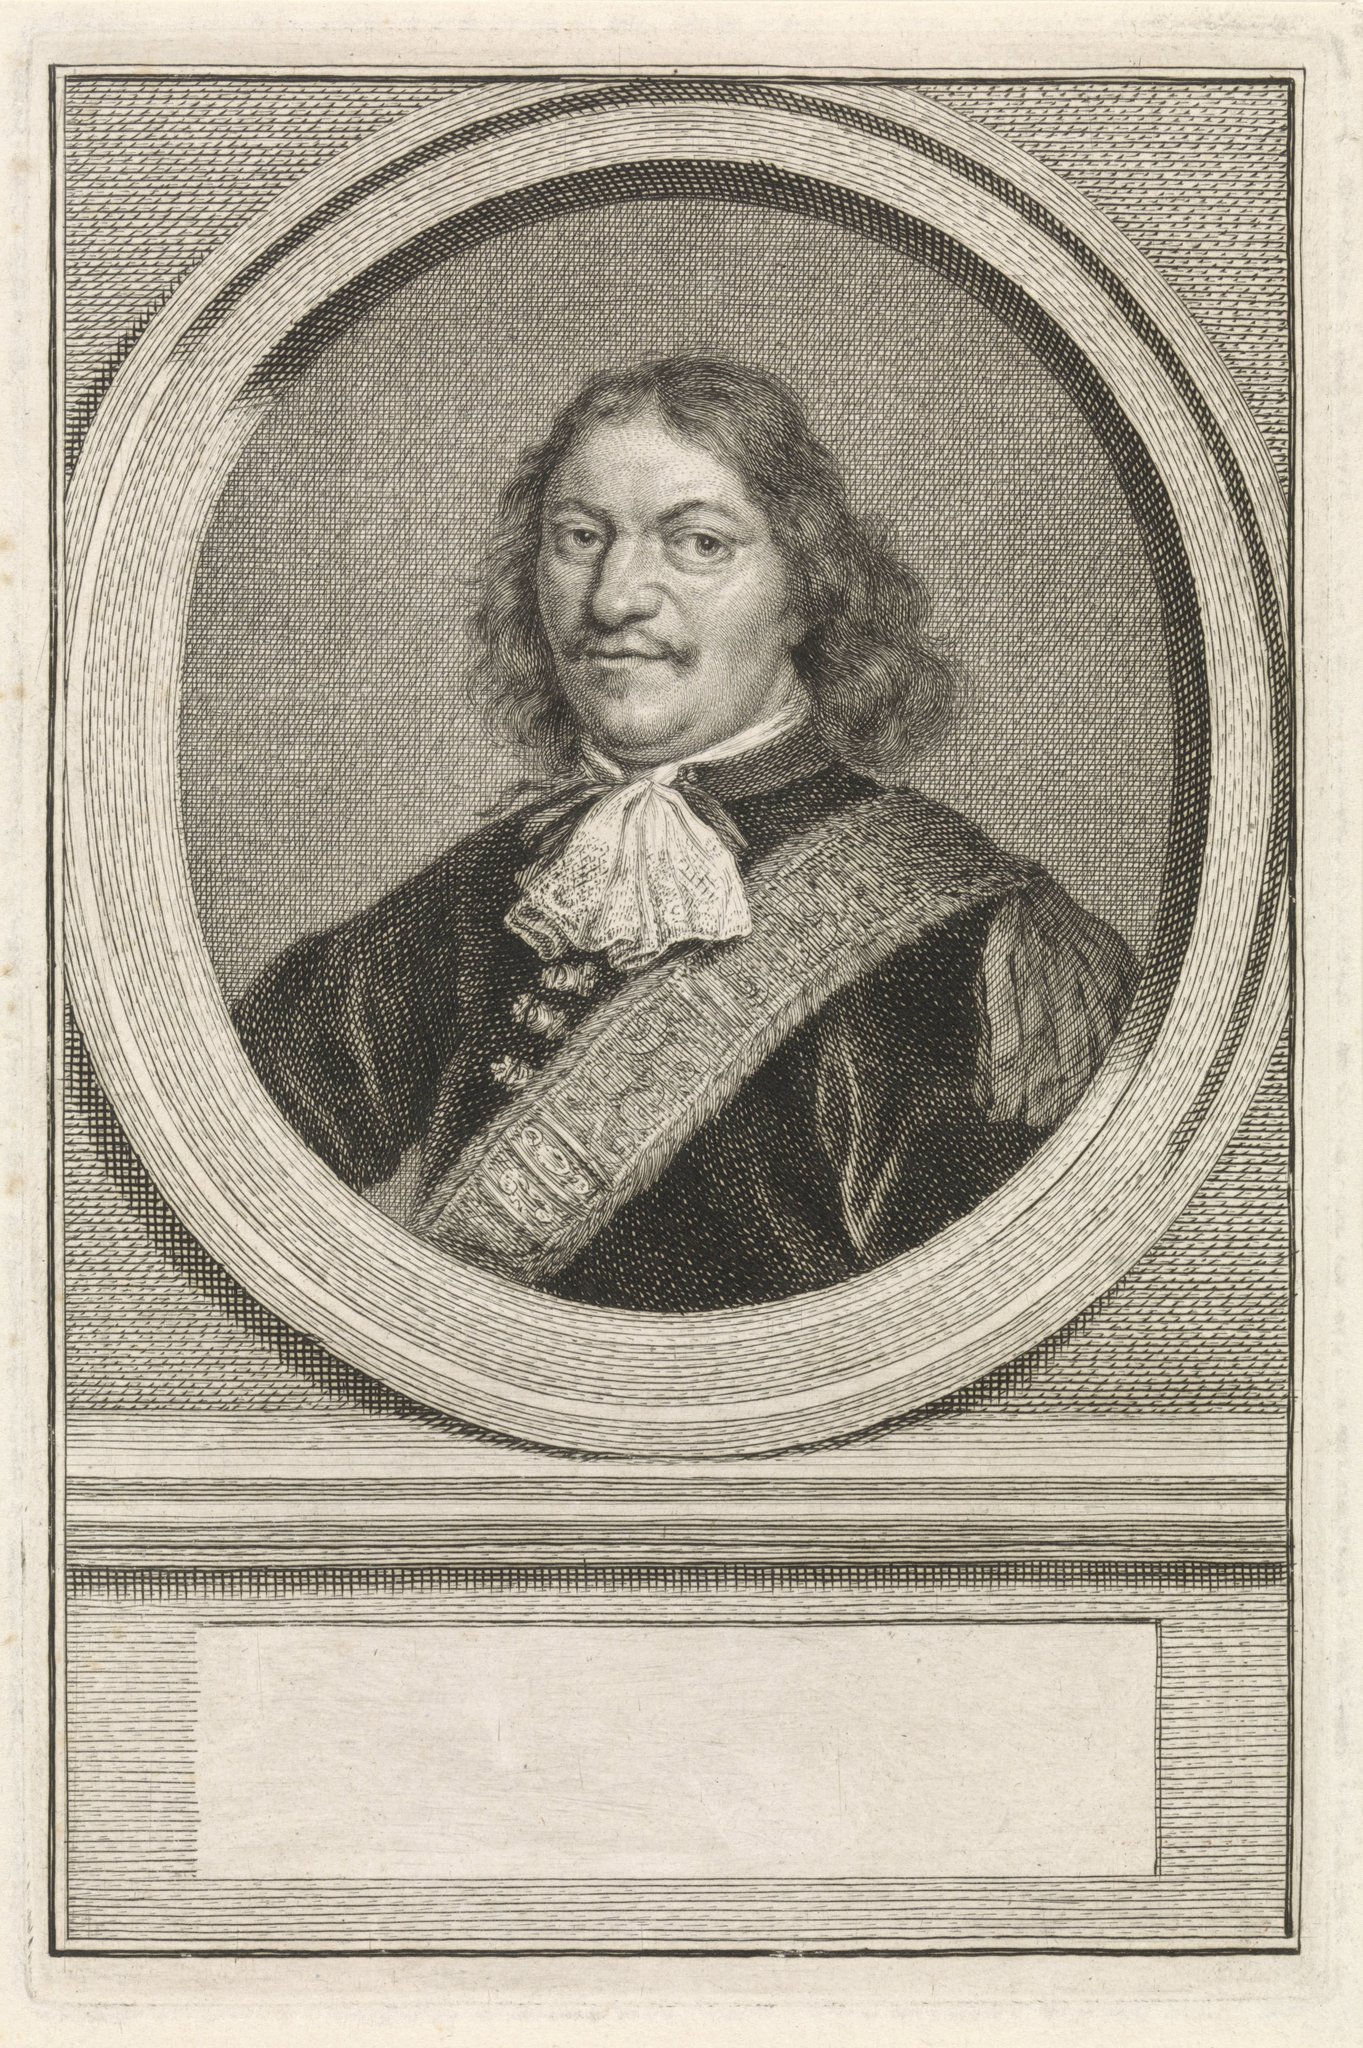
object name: print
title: Portret van Aert Jansz. van Nes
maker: jacob houbraken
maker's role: draughtsman, print maker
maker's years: 1698-1780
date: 1747-1759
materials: paper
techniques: engraving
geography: amsterdam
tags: schout-bij-nacht, luitenant-admiraal, zeekapitein, ordinaris, aert jansz. van nes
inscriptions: collector's mark: Lugt 2228, collector's mark: Lugt 240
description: Proefdruk van de prent gebruikt in: Jan Wagenaar, Vaderlandsche historie, vervattende de geschiedenissen der nu Vereenigde Nederlanden, inzonderheid die van Holland (...), 21 delen. Amsterdam, Johannes Allart, 1790-96.